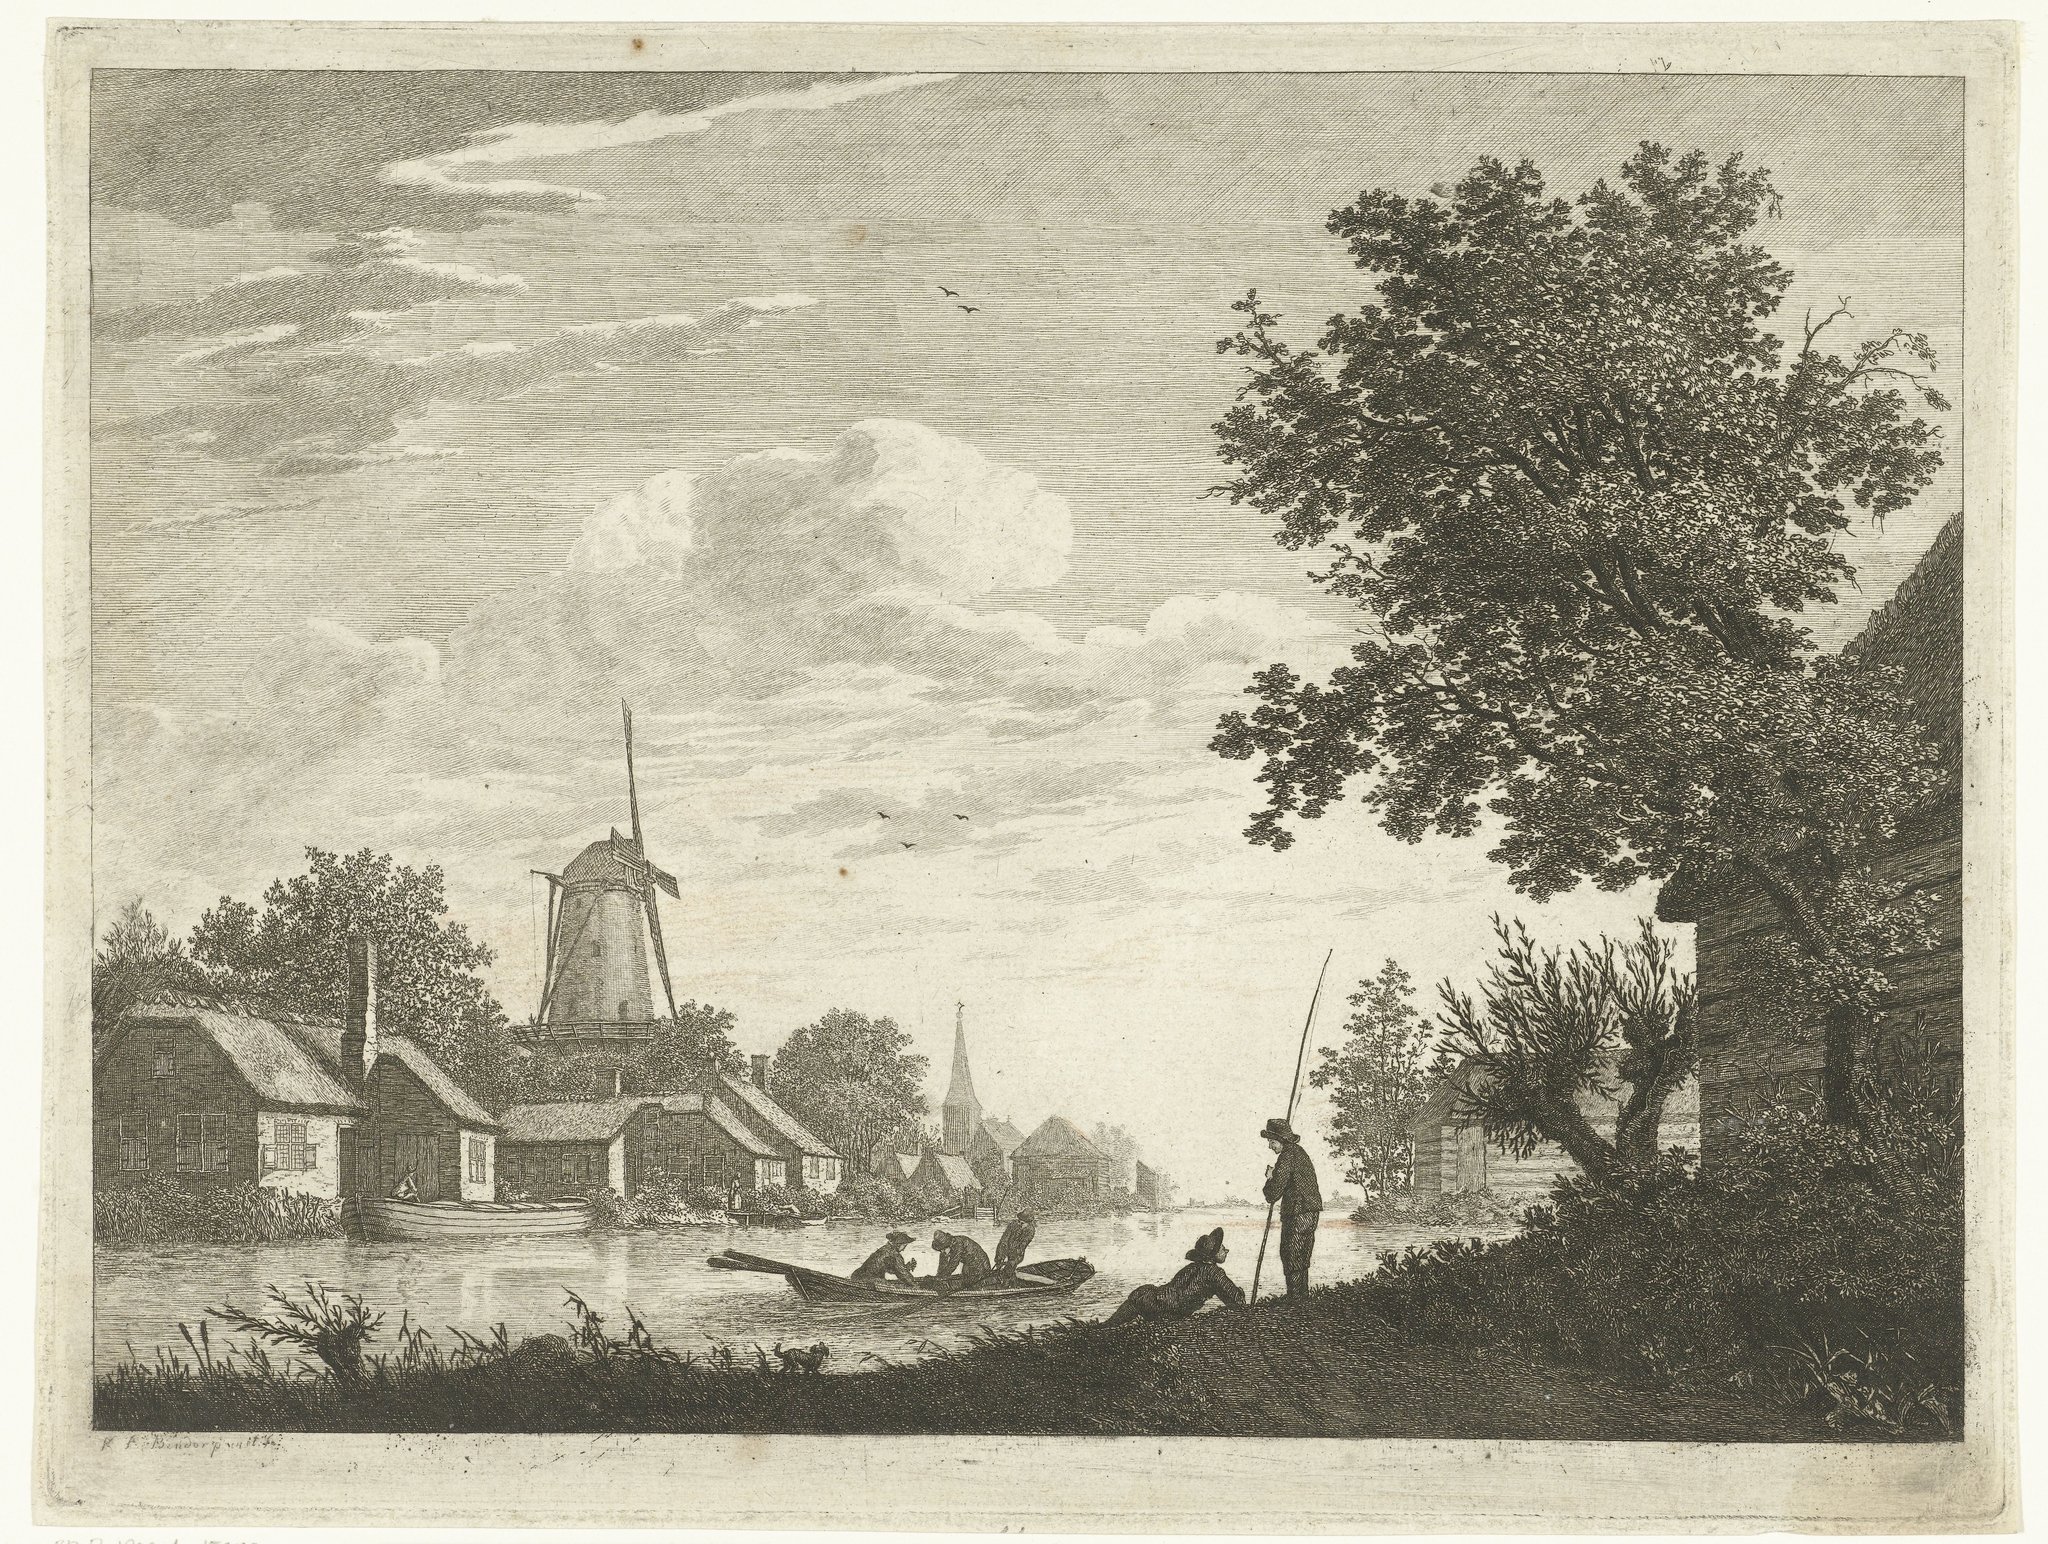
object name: print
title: Rivierlandschap met dorp met molen aan het water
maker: carel frederik bendorp (i)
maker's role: print maker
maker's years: 1736-1814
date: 1746-1814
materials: chalk, paper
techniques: etching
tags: river bank, windmill in landscape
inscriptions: collector's mark: Lugt 2228